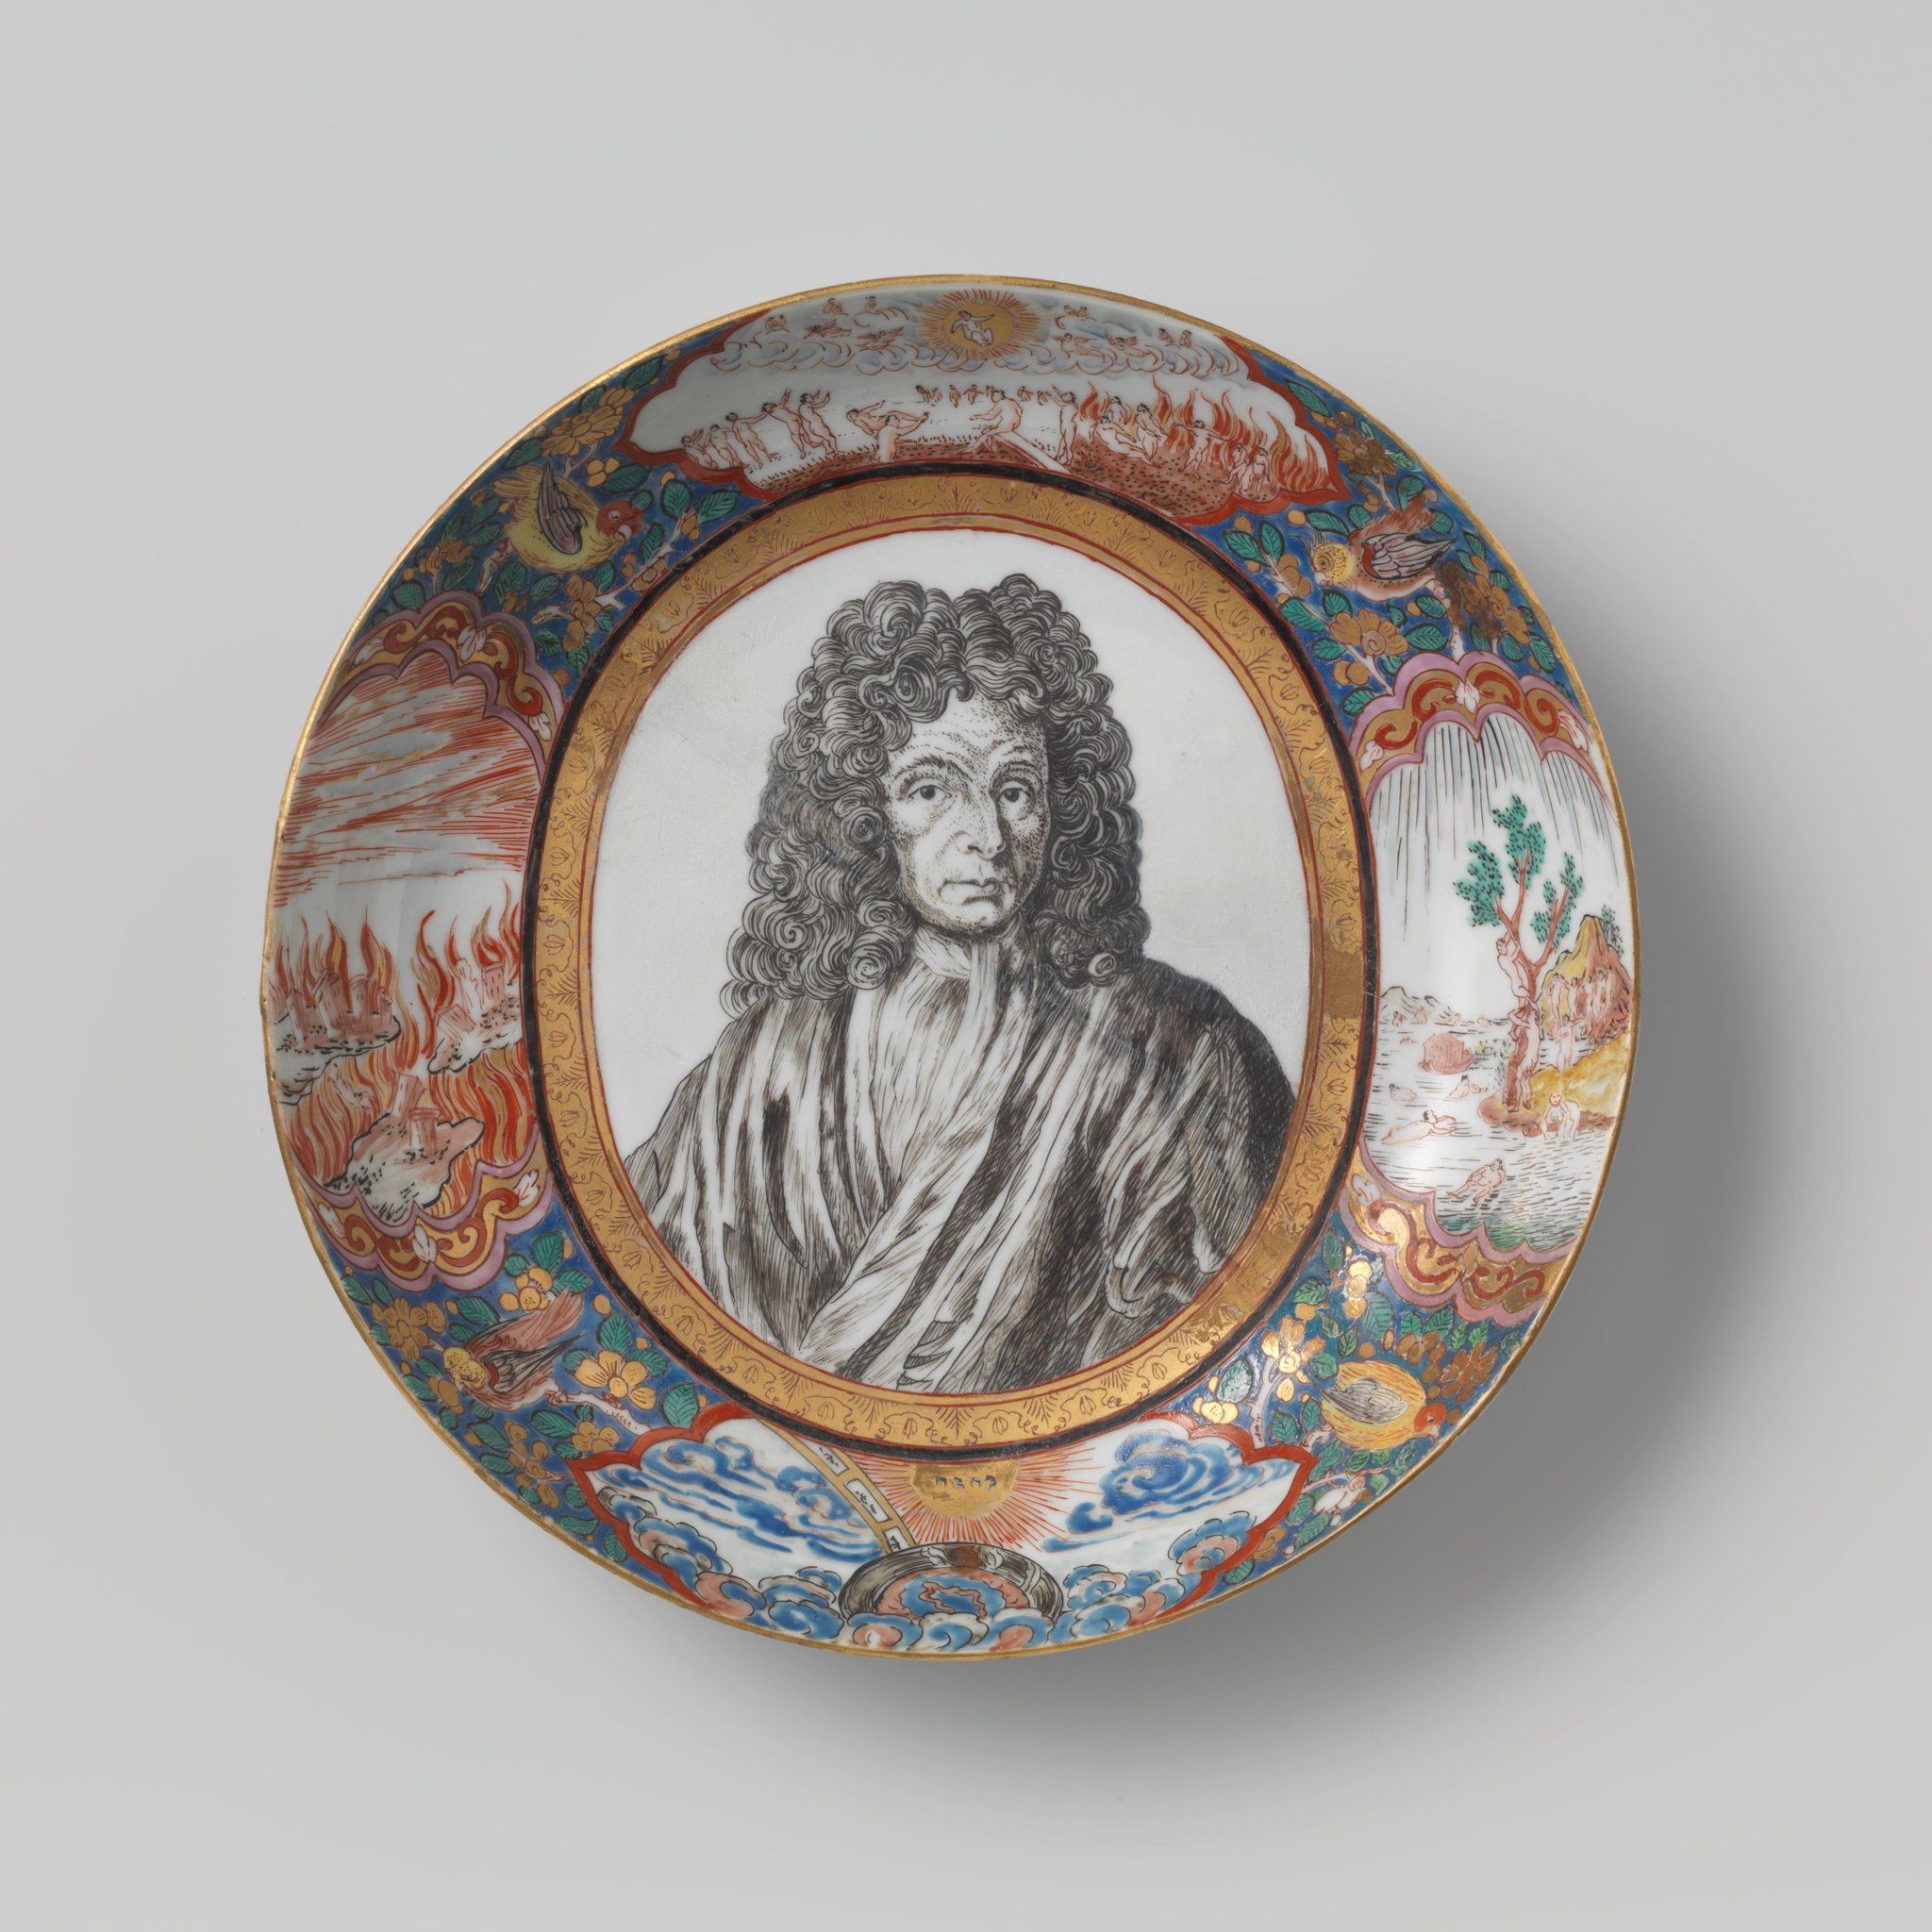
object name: dish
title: Saucer-dish with a portrait of theologist Willem Deurhof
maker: Anonymous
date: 1700-1724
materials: glaze, gold, paint, porcelain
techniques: firing, gilding, turning, vitrification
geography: china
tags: theologian, historical persons, northern netherlands, china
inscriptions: inscription: ‘Dit 's Deurhoff, die 't beleed van Cartes heeft hervormt De Ongodist met kragt van reeden bestormt Het hijlig kruysgeloof verdedigt; 't gode-leeven Met mond, in pen en daad op 't kragtigst voortgeschreeven: Dit is een flaauwe schets van 't weesen; maar zijn geest wort best bekend, van die zijn 'gulde'schriften leest’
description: Ronde schotel op voetring met hoge rand. Voorzijde: ovaal medaillon met gouden rand waarin het portret van Deurhoff. Aansluitend vier bijbelse taferelen. M.b. het laatste oordeel, m.l. de ondergang van Sodom en Gomorra, m.r. de zondvloed en m.o. Hebreeuwse letters in lucht (JAWEH). Vergulde rand met geometrische en plantmotieven, afgewisseld door cartouches met vogels.